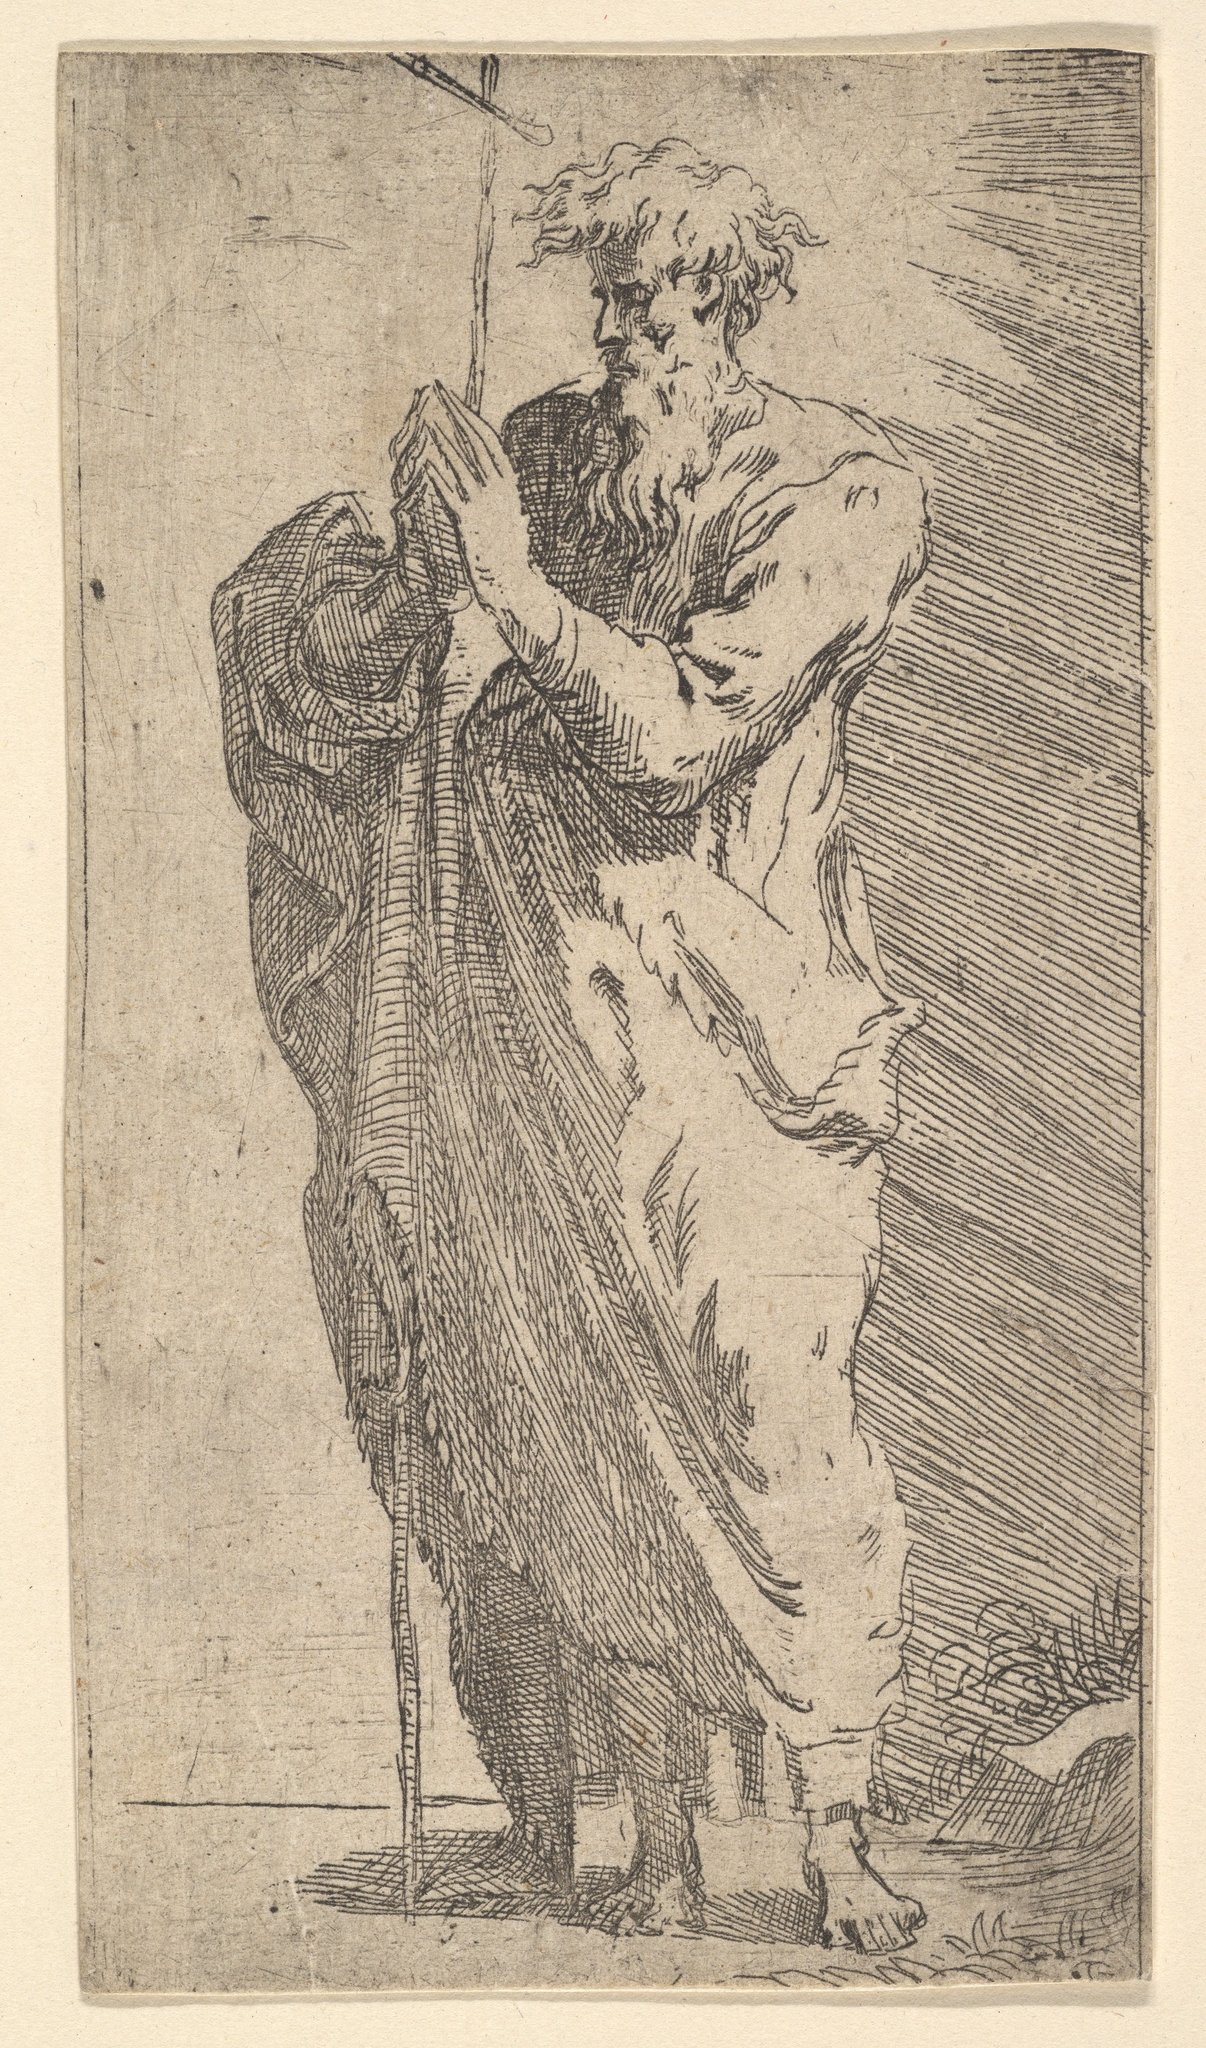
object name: print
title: Saint Philip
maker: parmigianino (girolamo francesco maria mazzola)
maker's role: artist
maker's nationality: italian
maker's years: 1503-1540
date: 1501-1533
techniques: etching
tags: saints